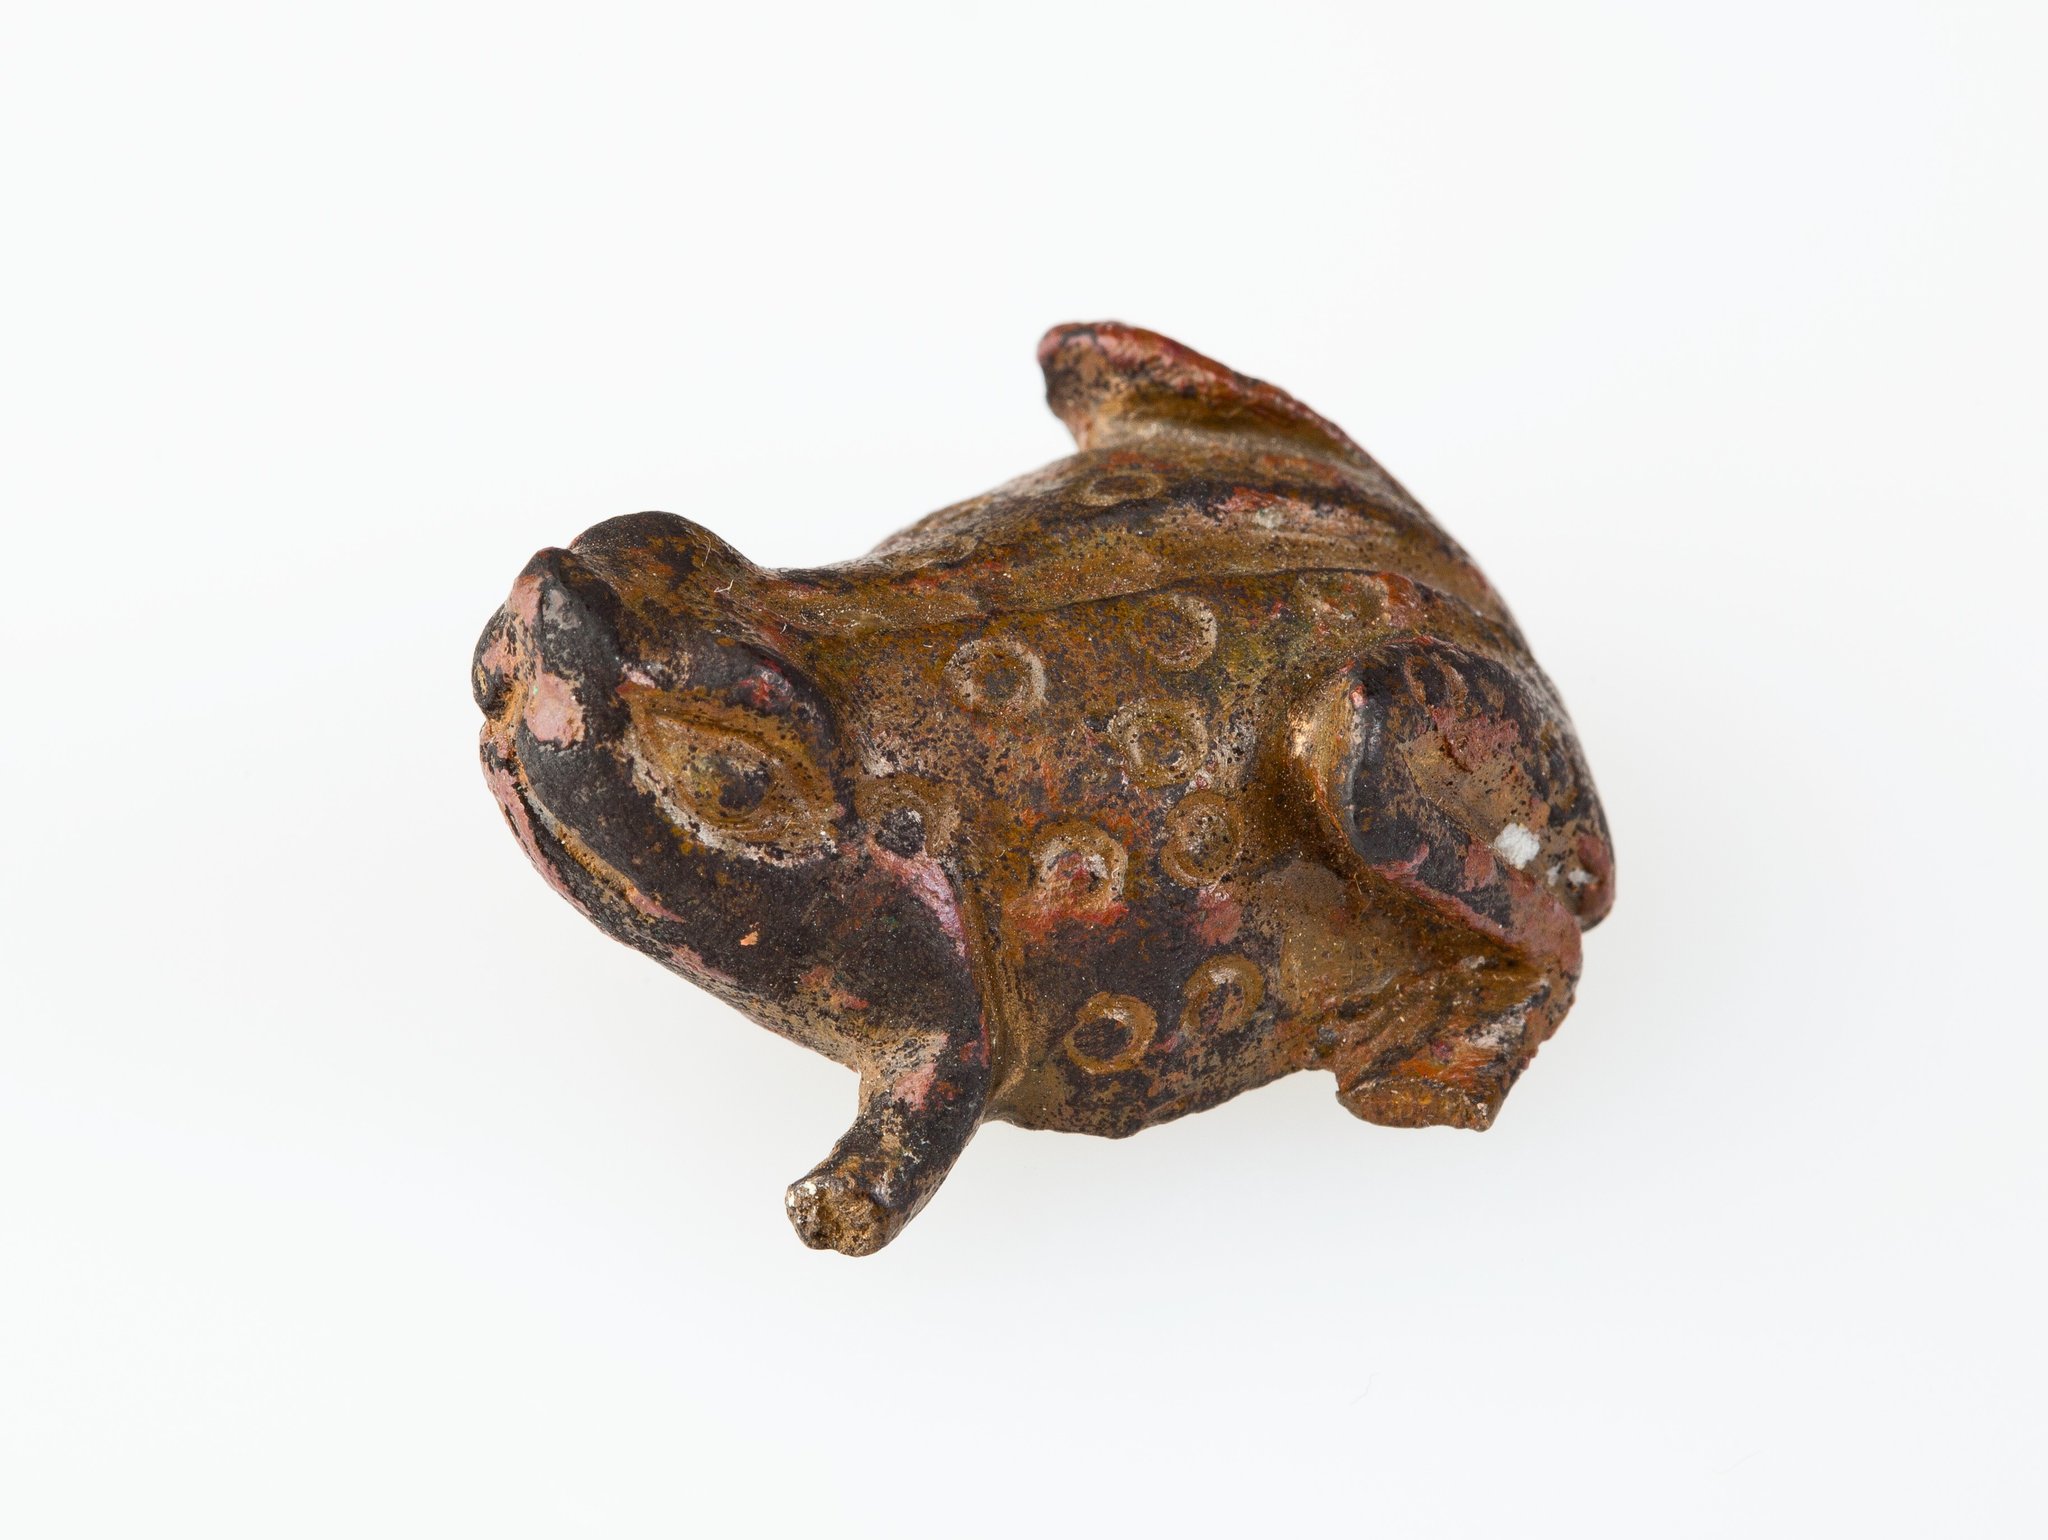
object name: amulet, frog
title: Frog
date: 688-525 BCE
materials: copper alloy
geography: egypt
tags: frogs